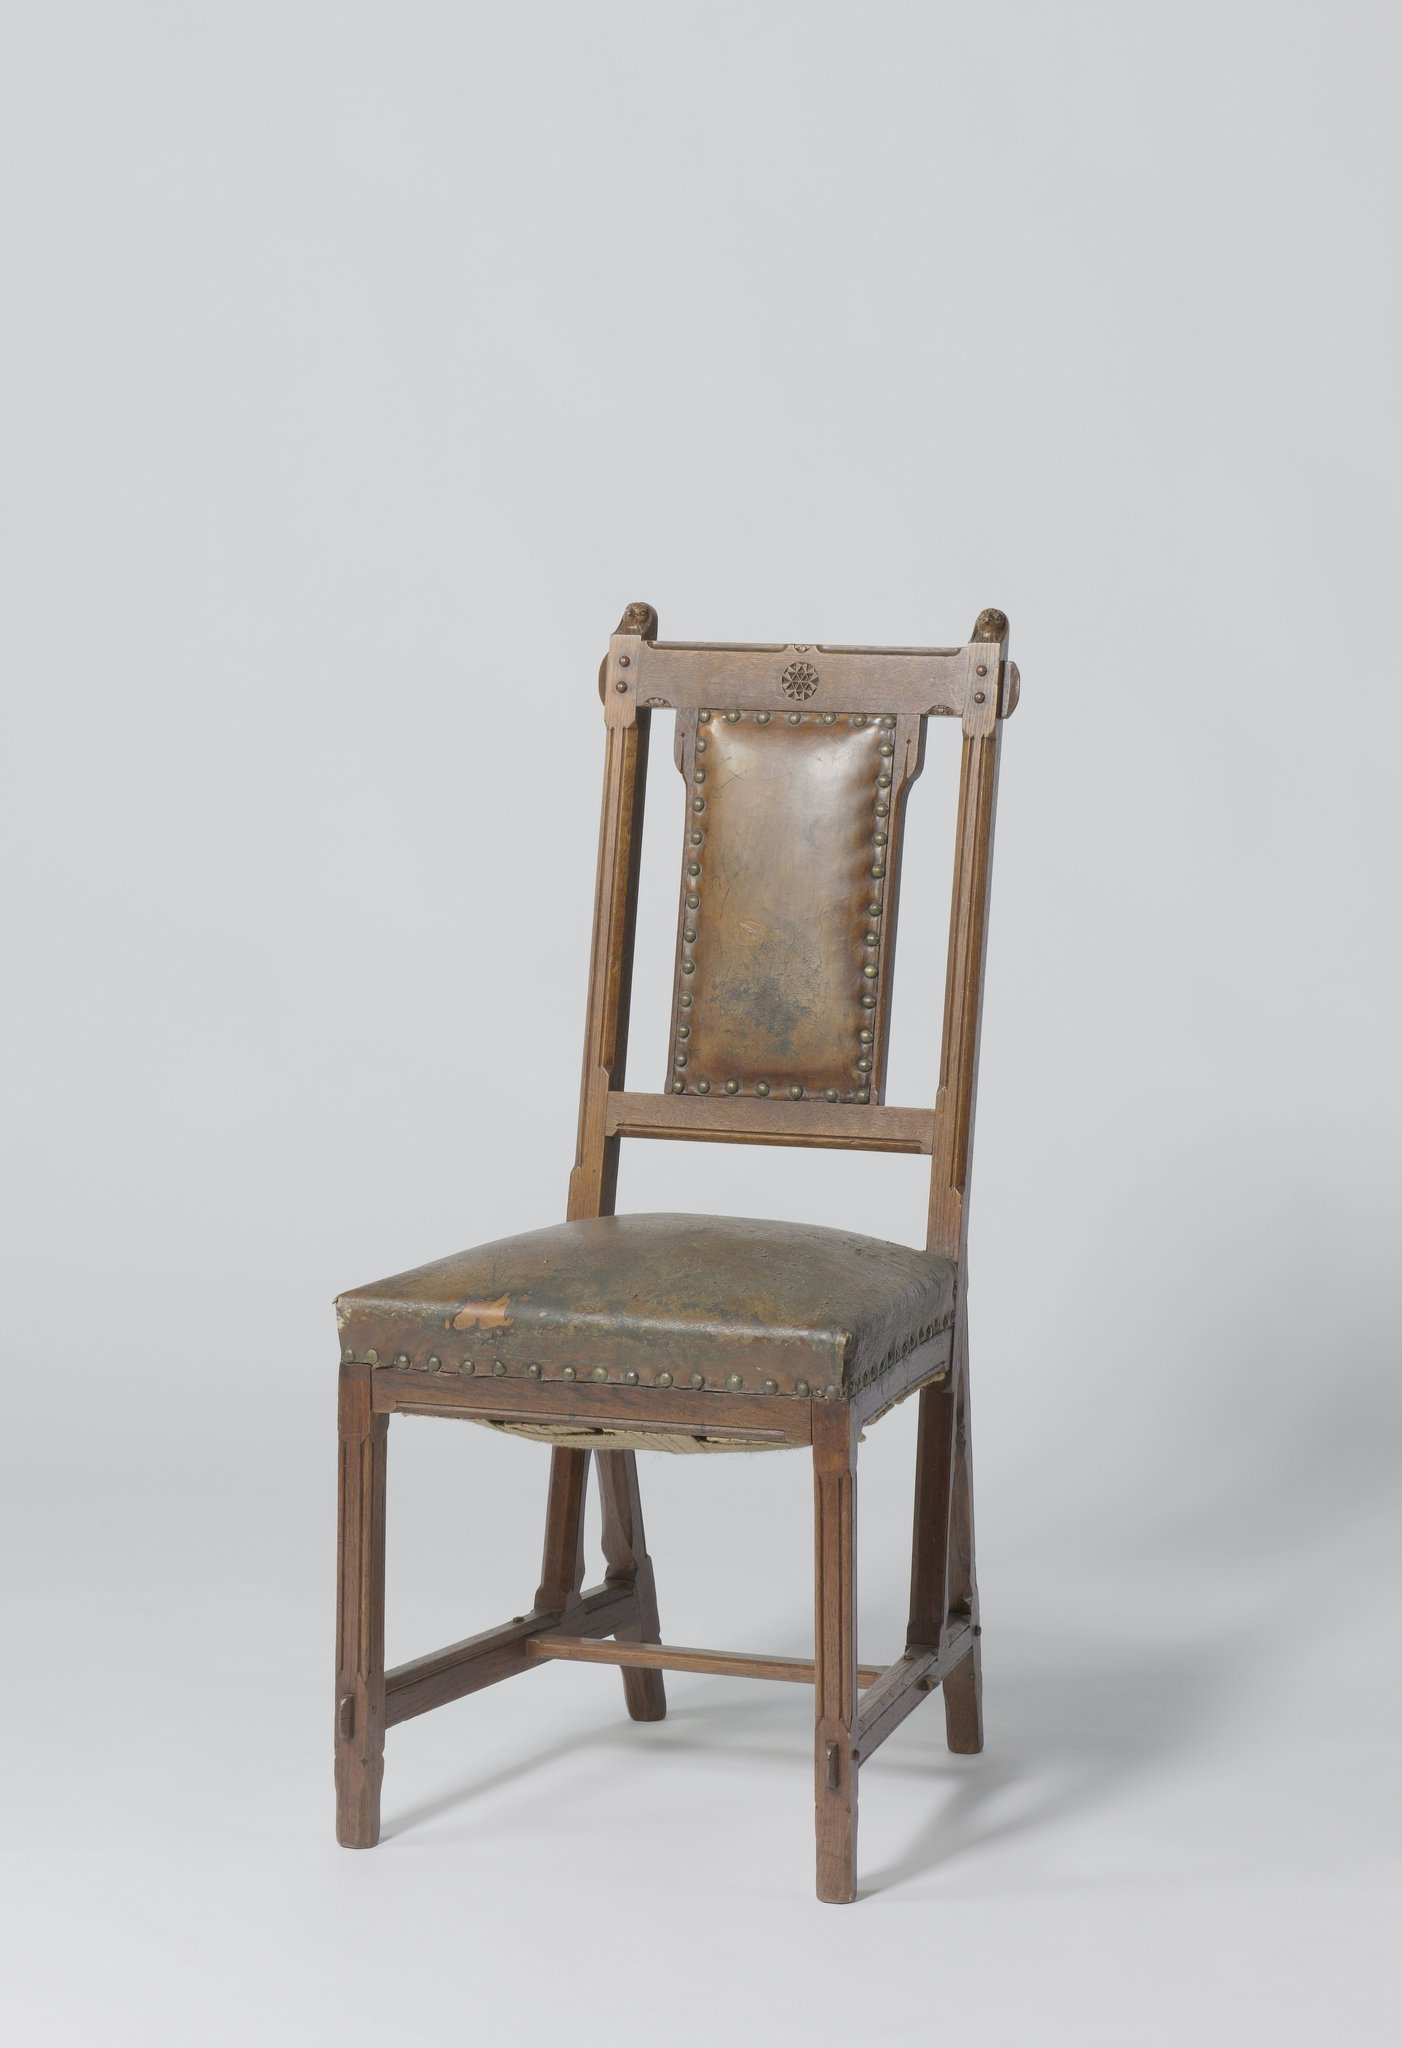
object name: furniture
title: Stoel met een bruin lederen bekleding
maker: hendrik petrus berlage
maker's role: draughtsman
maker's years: 1856-1934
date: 1902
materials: leather, wood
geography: amsterdam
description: Stoel van eikenhout. De voor- en achterpoten zijn onderling verbonden door middel van een H-vormig kruis met pen- en gatverbindingen, waarvan de pennen door de poten heen steken. De schuinstaande gebiljoeneerde rugstijlen eindigen in vogelkoppen en rusten op het kruis. De leuning rust op stutten ter hoogte van de zitting en deze dienen tevens als achterpoten. De rugleuning is zowel boven als onder verbonden door een tussenregel. De bovenregel bevat in het midden een gesneden stervorm. Tussen de regels bevindt zich een paneel dat bekleed is met bruin leer en vastgezet is met koperen nagels. Ook de zitting is bekleed met bruin leer en vastgezet met koperen nagels.